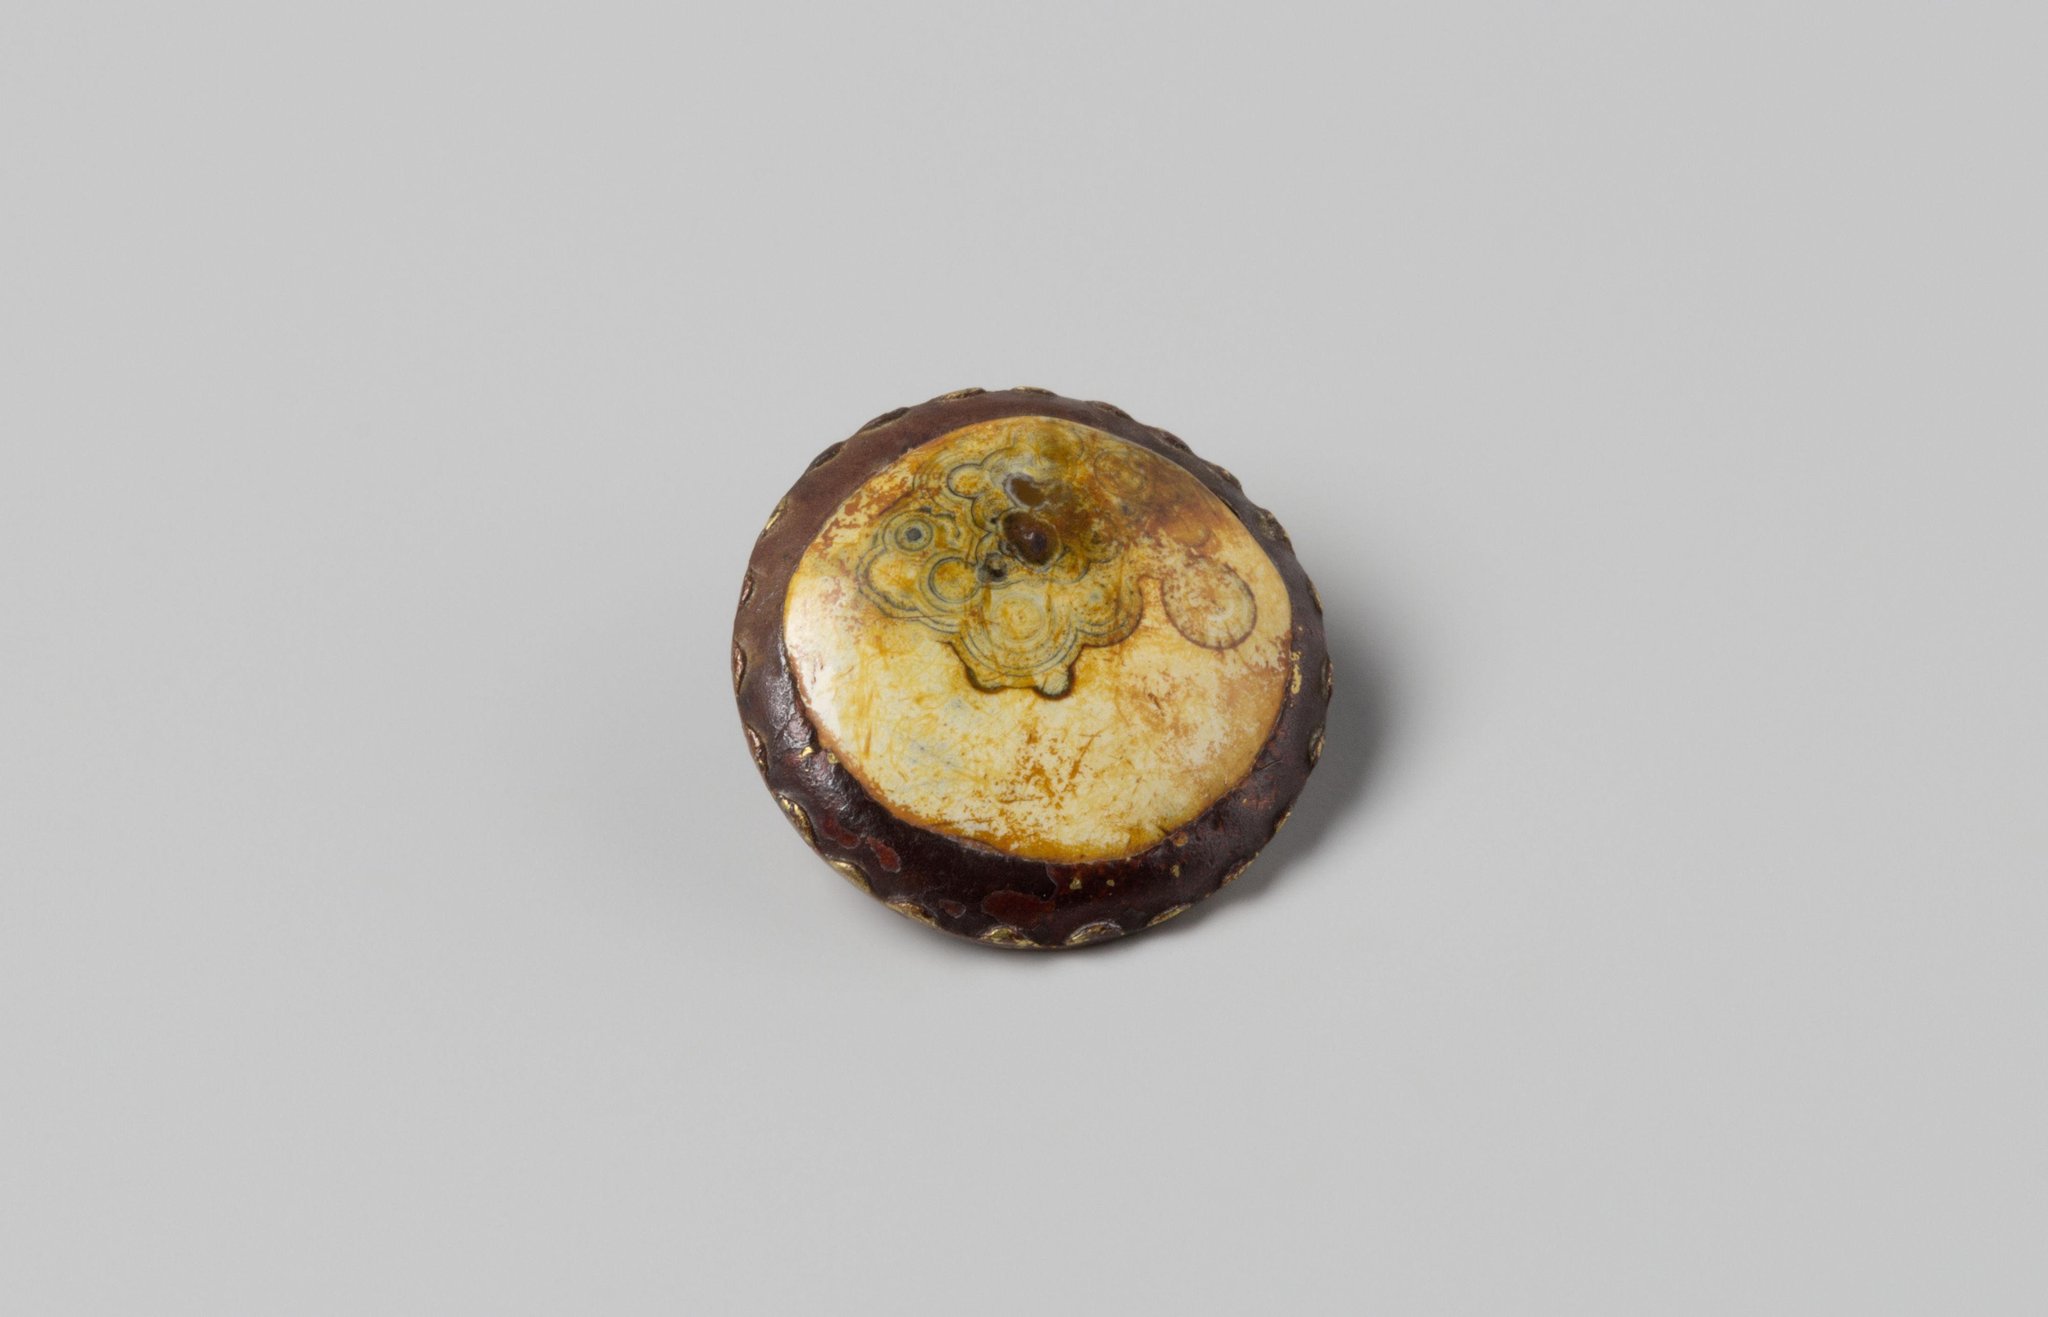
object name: button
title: Knoop uit het wrak van de Oost-Indiëvaarder Hollandia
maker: Anonymous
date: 1700-1743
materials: gold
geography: netherlands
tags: verenigde oostindische compagnie, hollandia (schip), annet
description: Knoop. Button; (1) flat base with moulded rim (1.7d), loop-shank, domed stone setting.